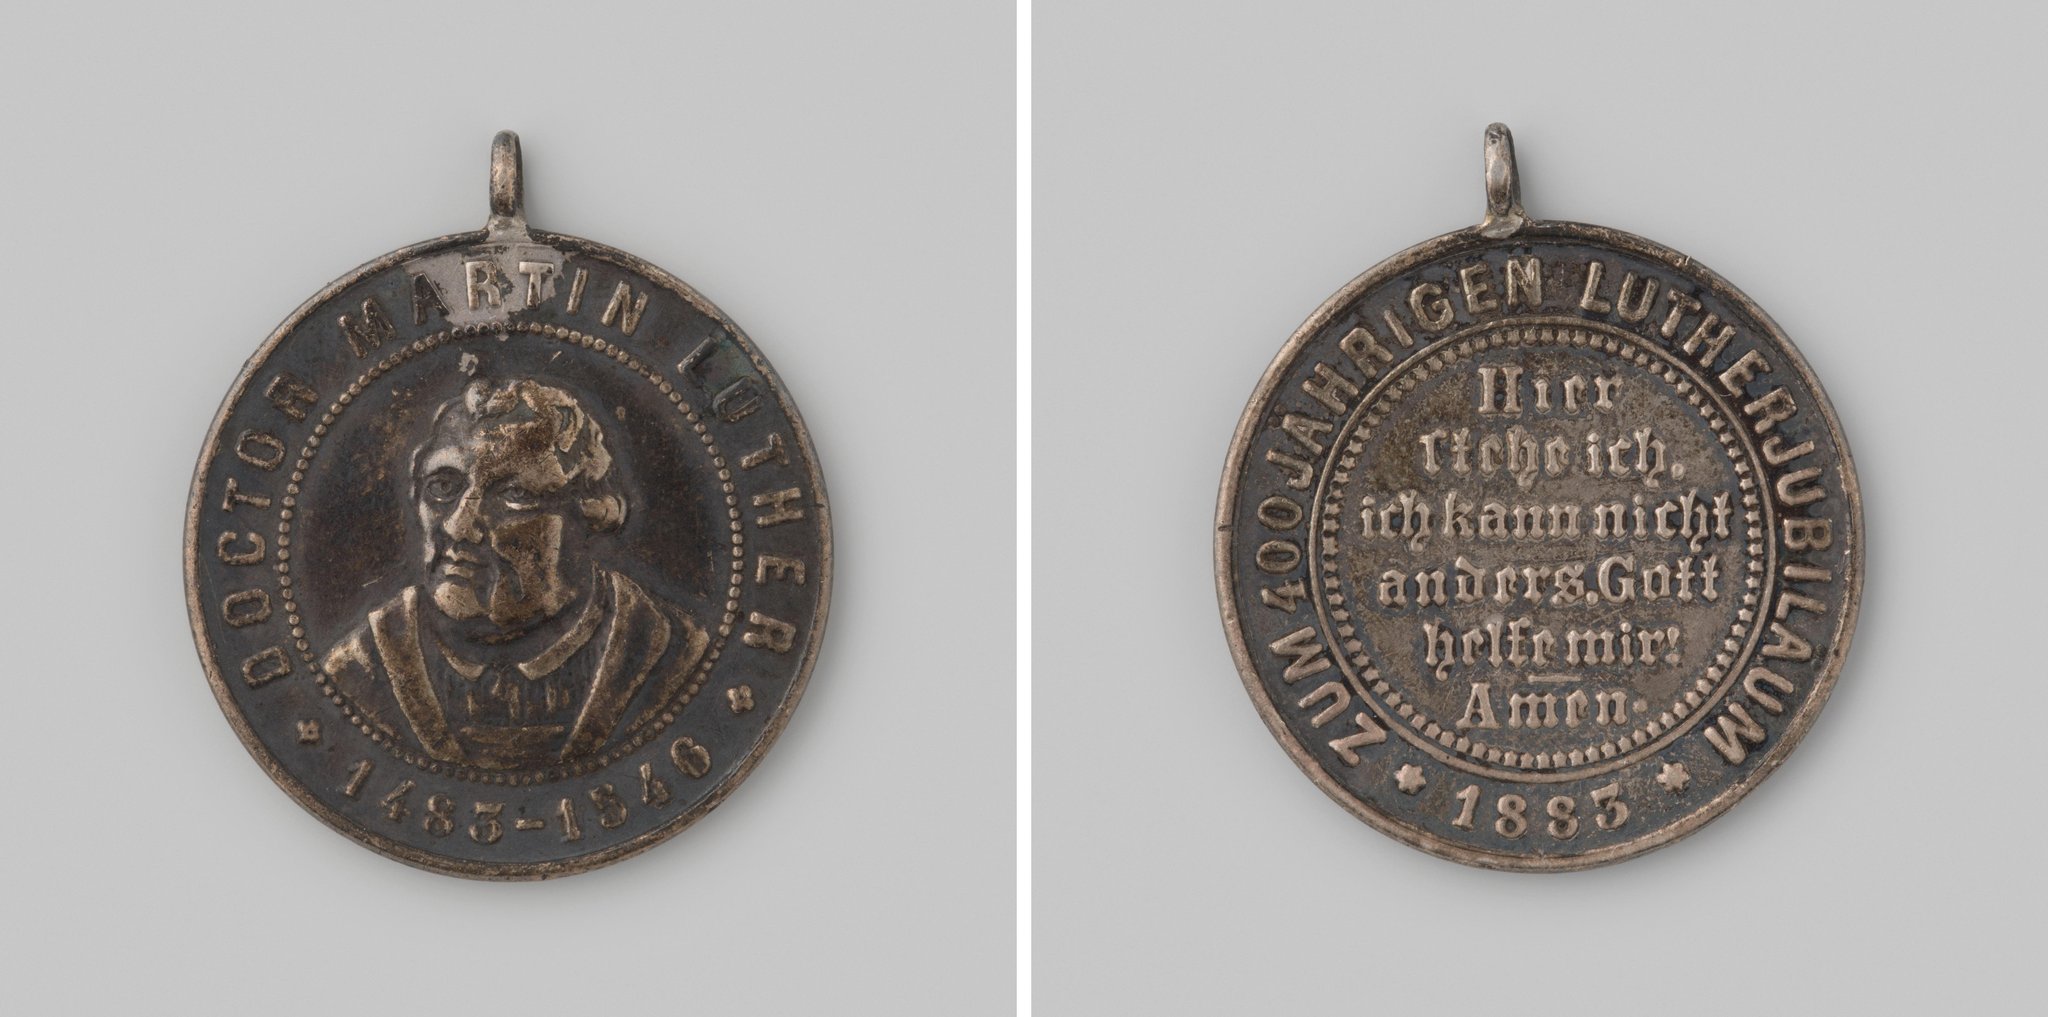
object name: history medal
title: Vierhonderdjarige herdenking van de geboorte van Maarten Luther 1883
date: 1883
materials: silver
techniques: striking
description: Zilveren penning met draagoog, op de voorzijde het borstbeeld van Luther half naar links met omschrift, op de keerzijde zes regels tekst met omschrift.